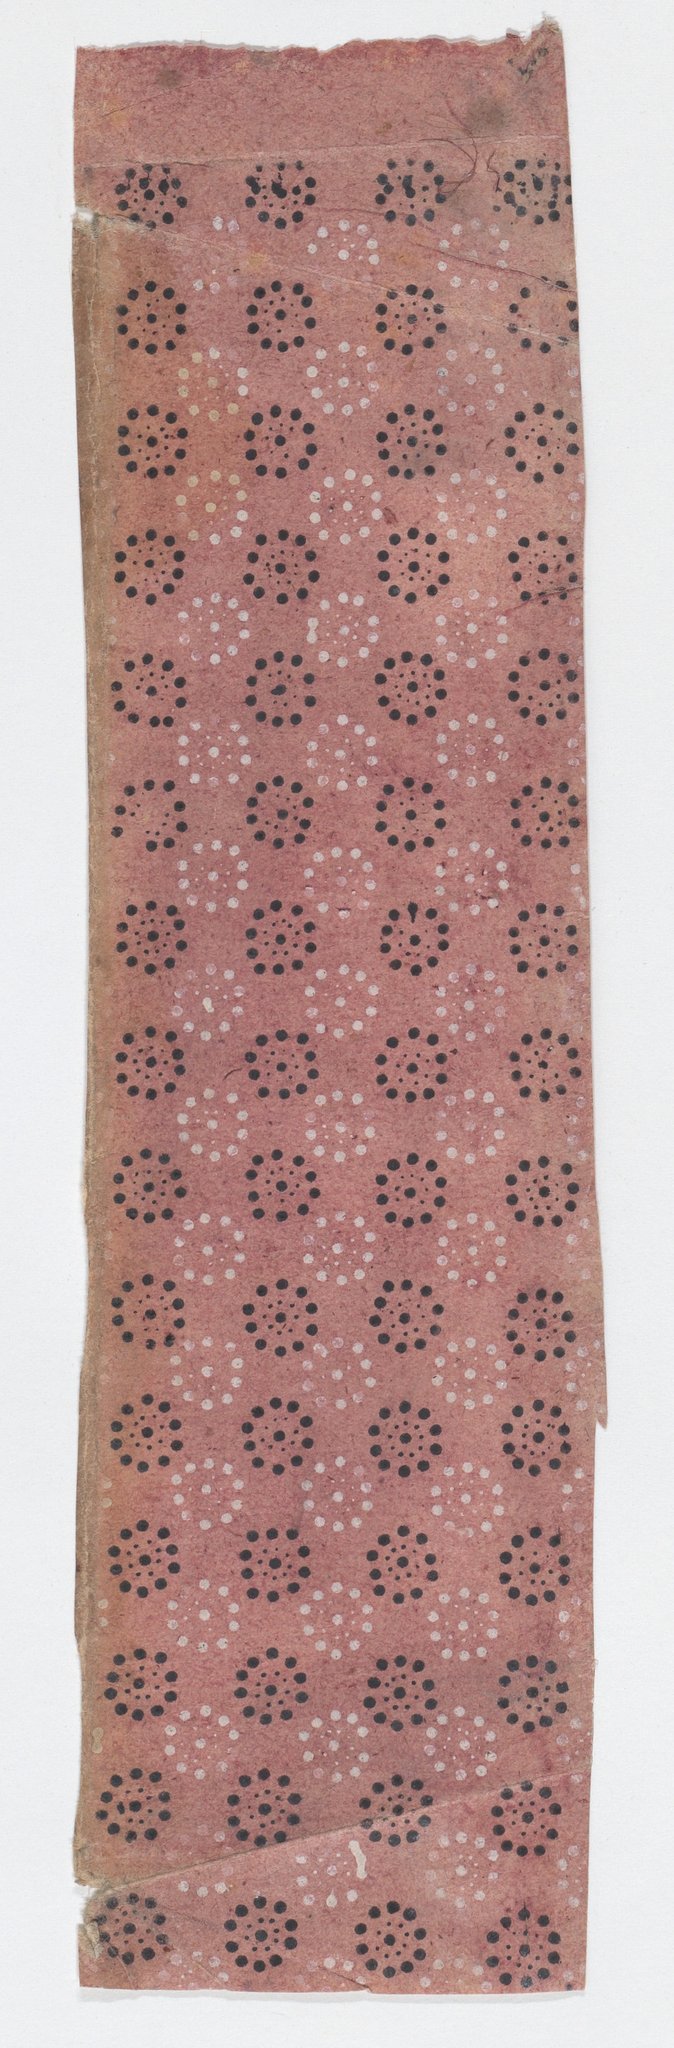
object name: print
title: Fragment of a sheet with a pattern of dots in circles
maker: Anonymous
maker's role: artist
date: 1801-1900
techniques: relief print